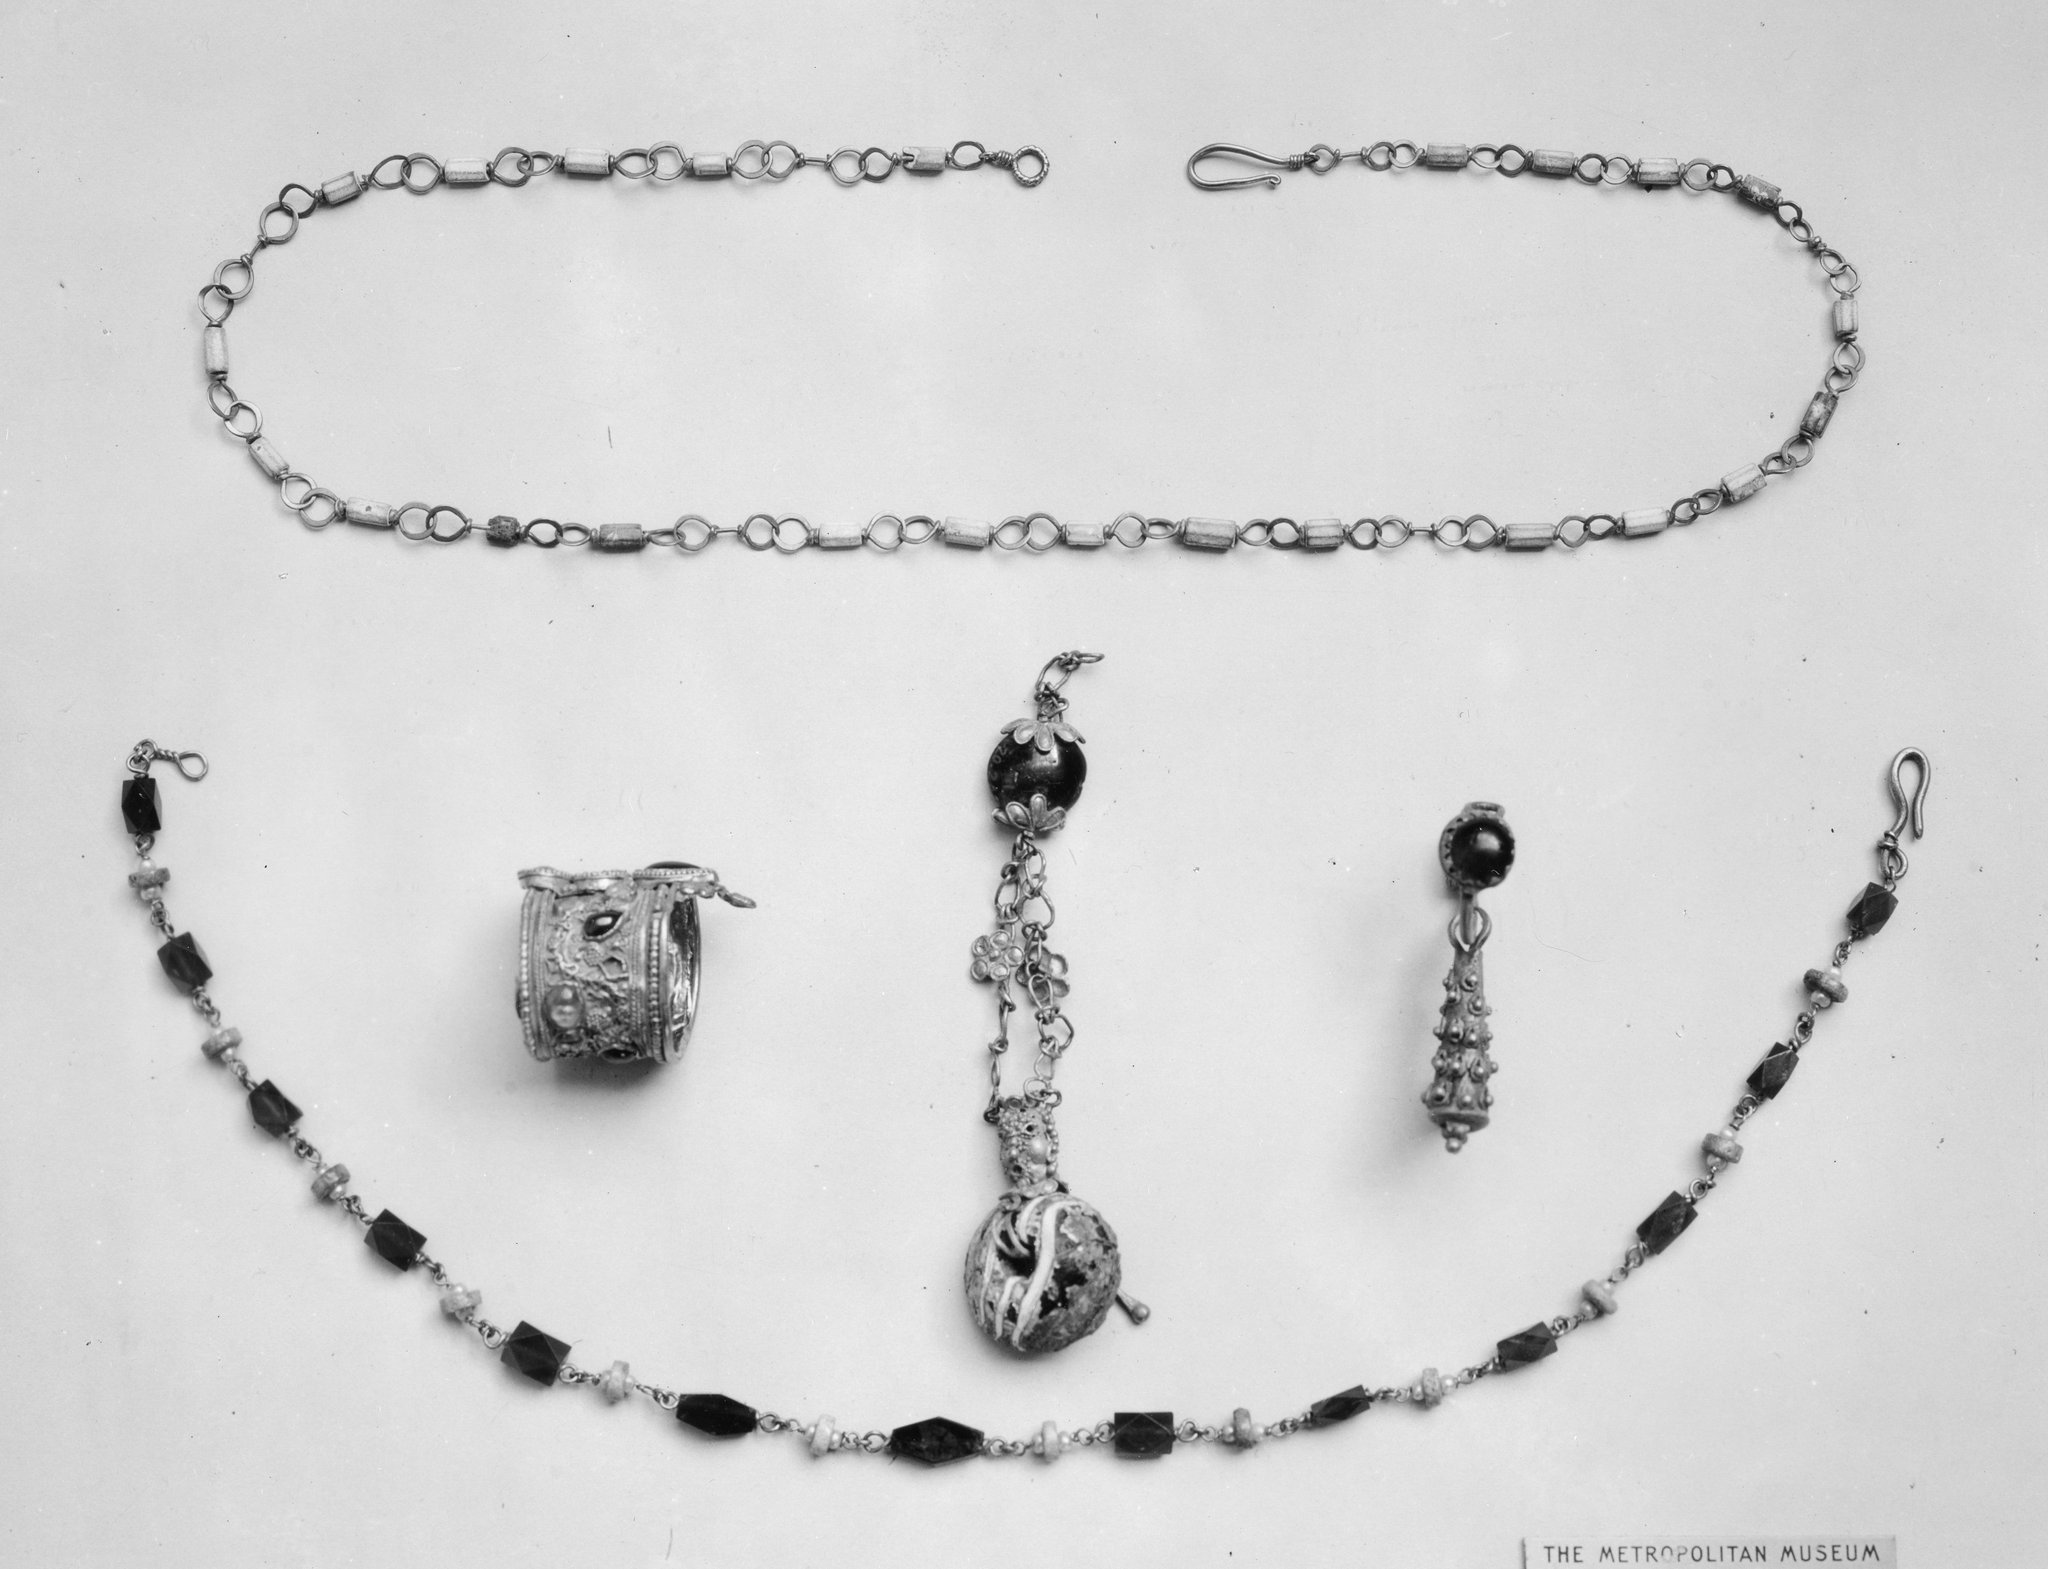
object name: ring with serpent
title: Gold ring set with garnets and amethysts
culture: greek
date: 200-101 BCE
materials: amethyst, garnet, gold